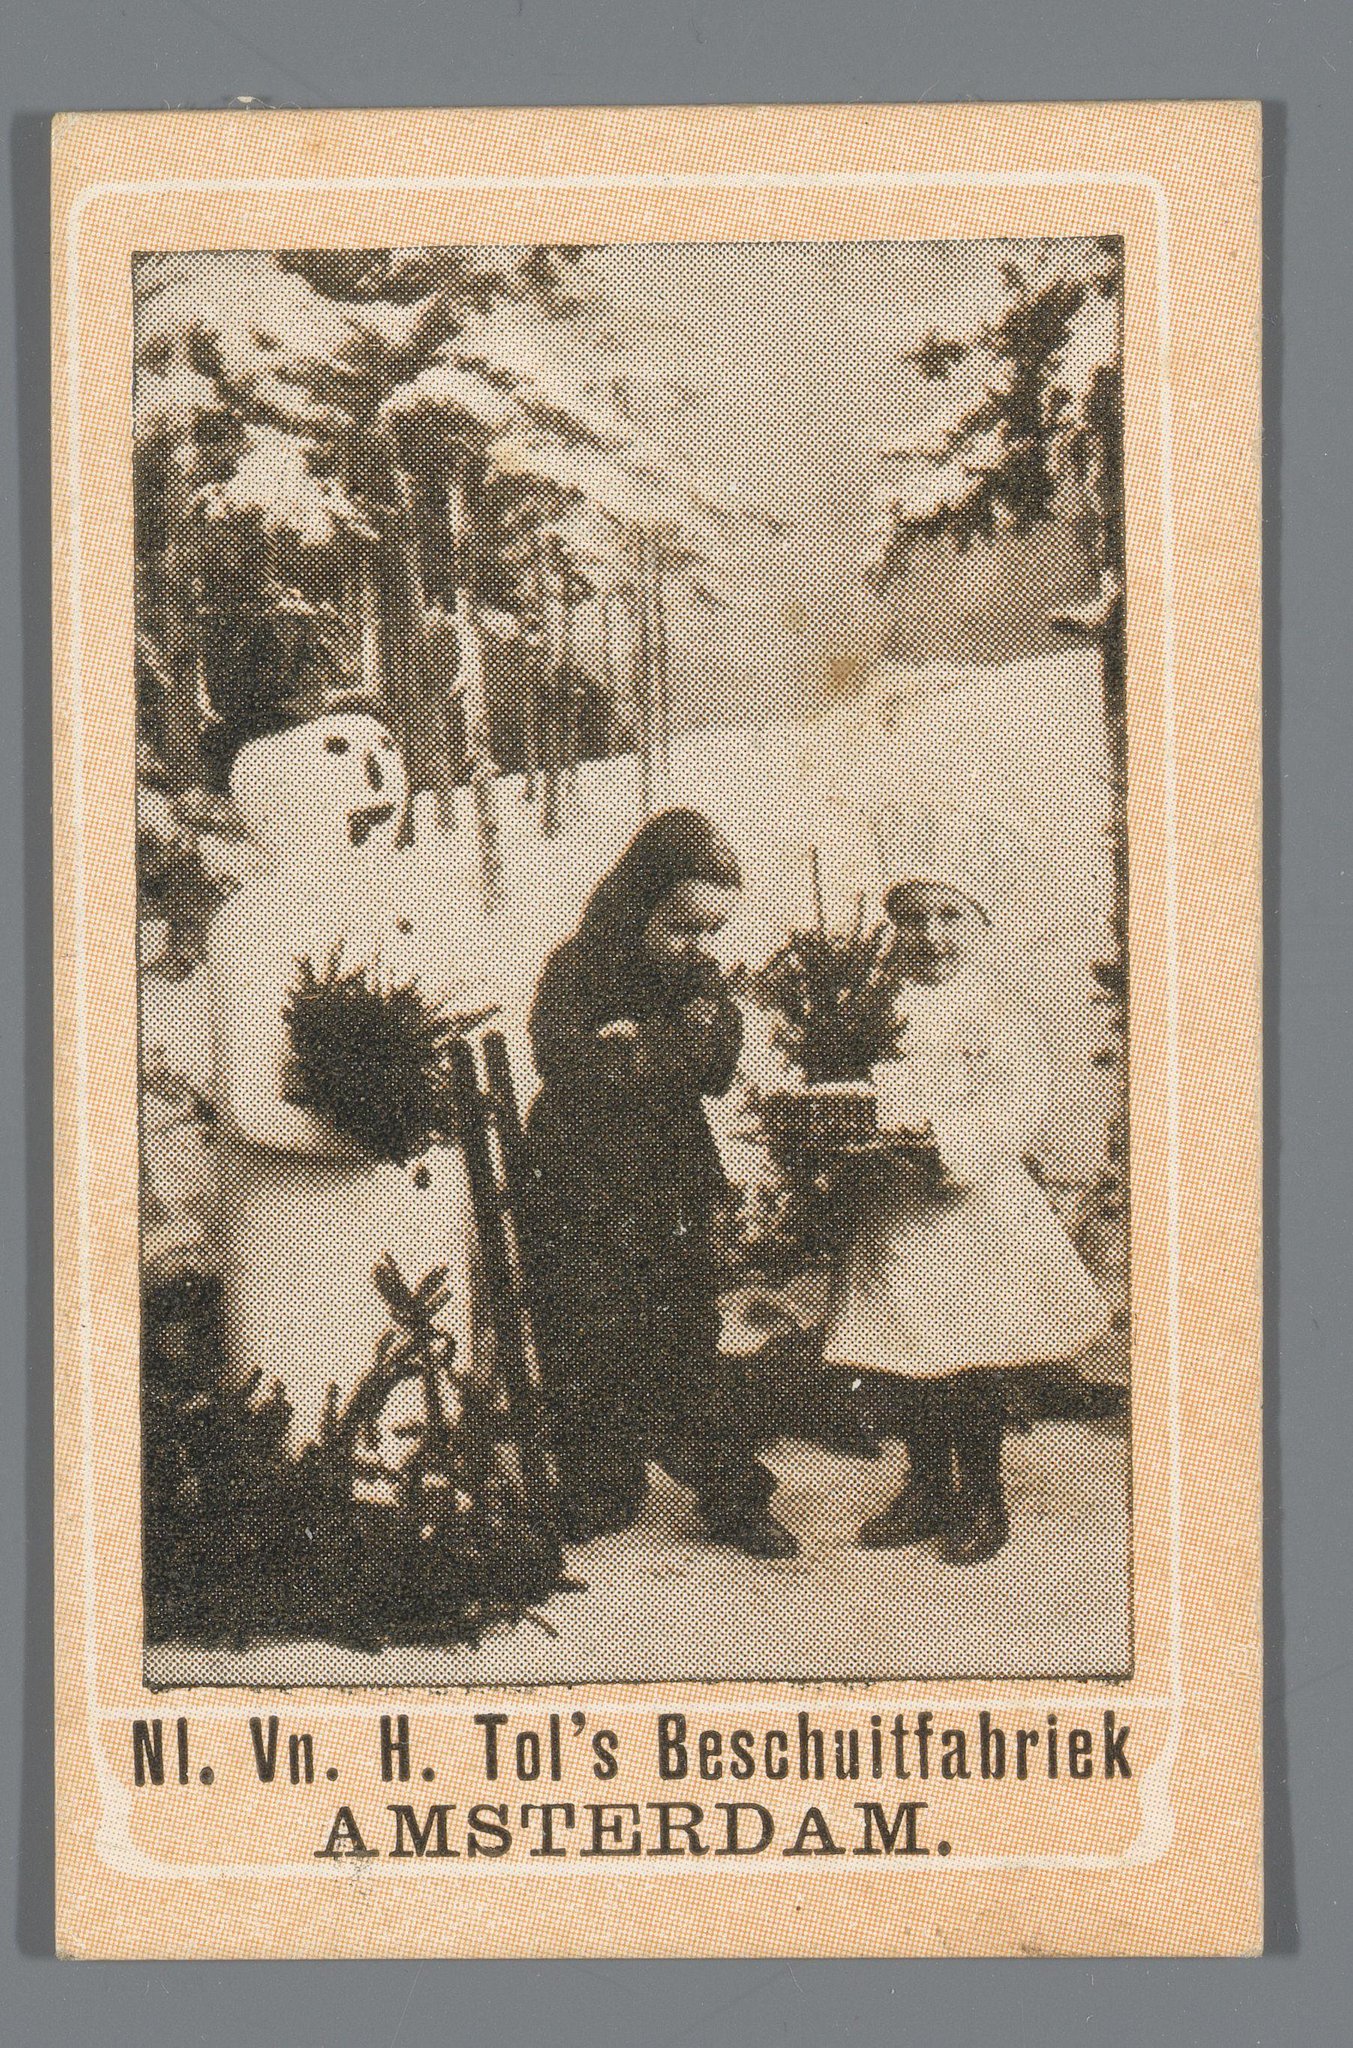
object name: photomechanical print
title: Twee onbekende kinderen bij een sneeuwpop, reclame voor Nl. Vn. H. Tol's Beschuitenfabriek Amsterdam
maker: Anonymous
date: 1895-1910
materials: paper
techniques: autotype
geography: netherlands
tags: (making a) snowman, netherlands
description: Dergelijke prenten stonden bekend als 'zwartjes'. Men verkreeg ze bij aanschaf van bepaalde merken thee, cacao, sigaretten, beschuit, etc. om te verzamelen. Er waren speciaal voor de 'zwartjes' verzamelalbums in omloop.